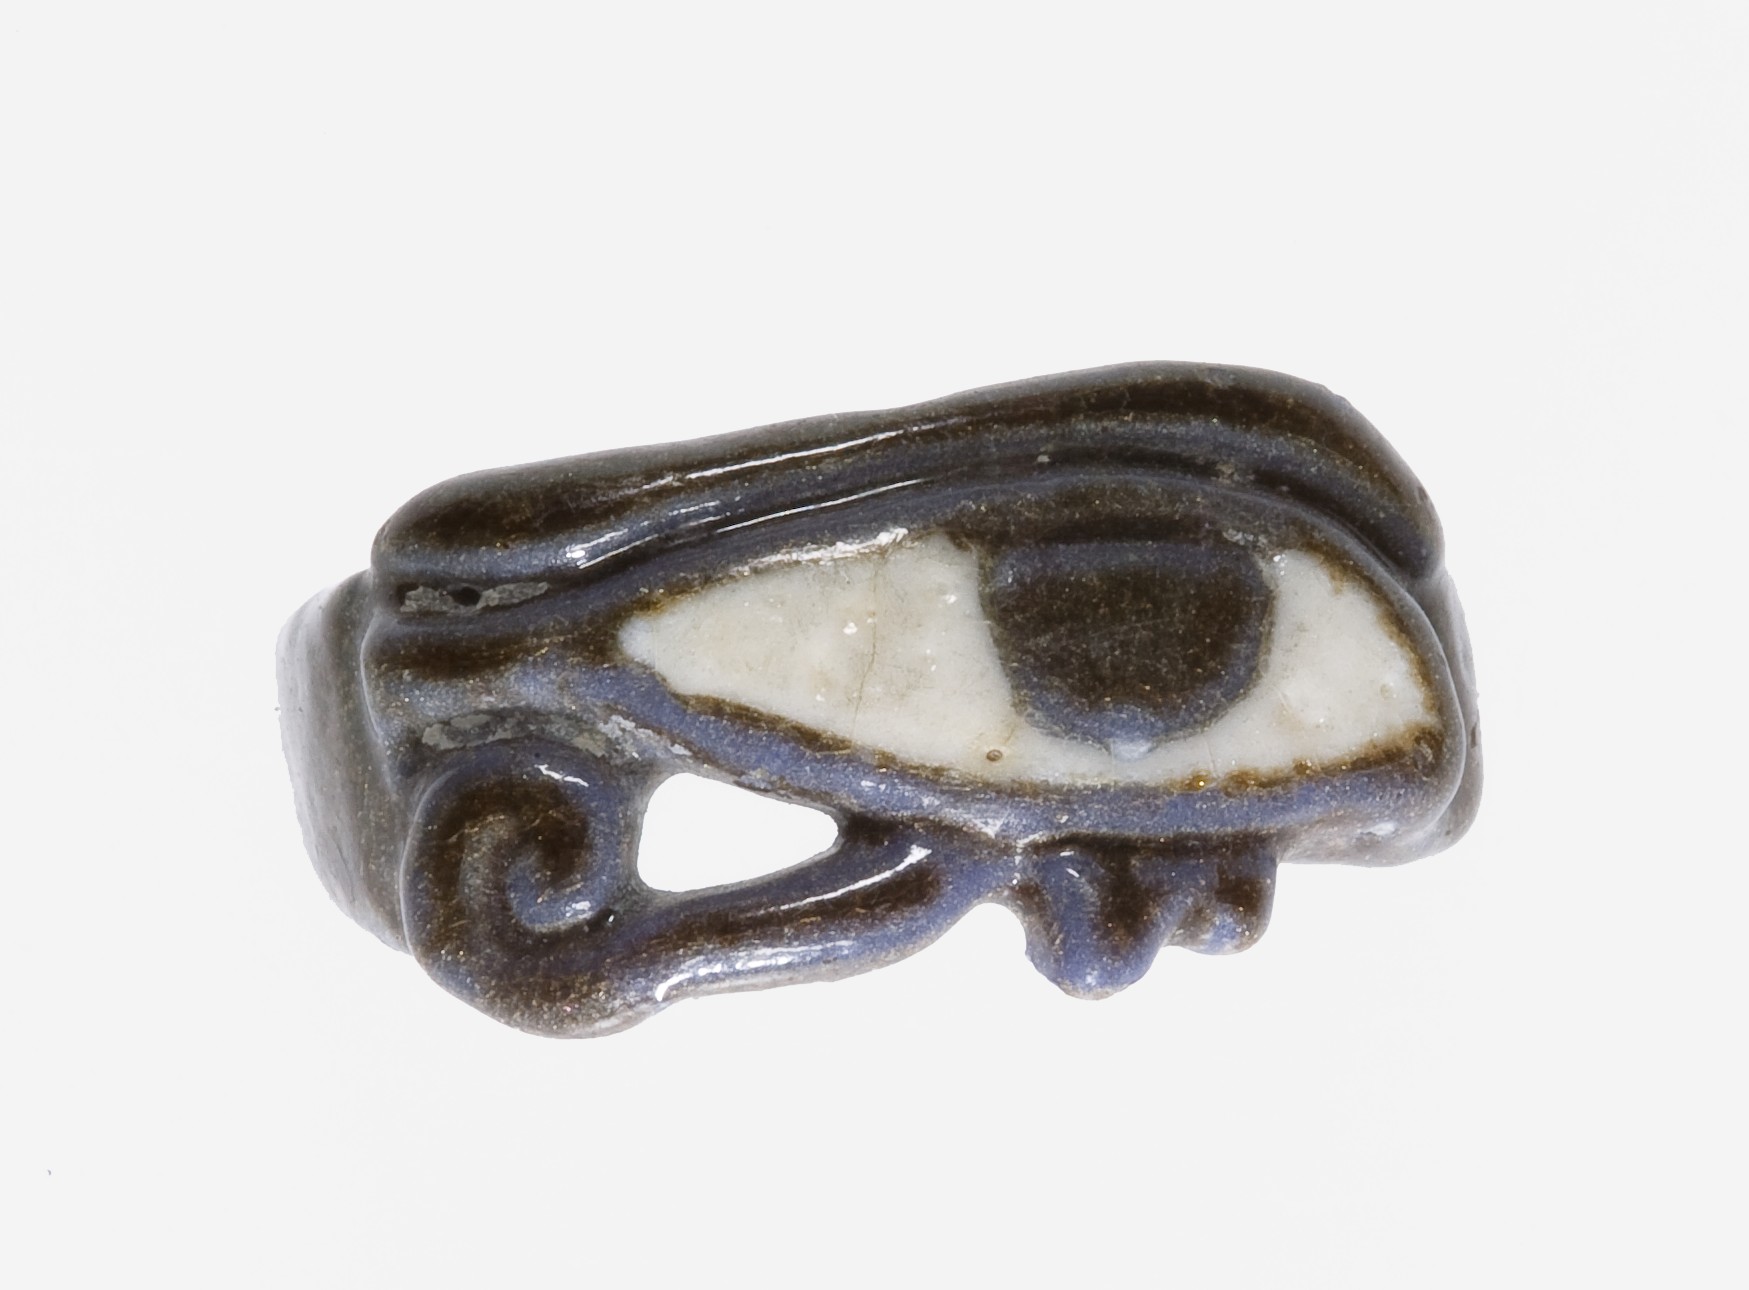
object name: ring, sacred eye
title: Sacred Eye Ring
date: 1390-1352 BCE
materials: faience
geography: egypt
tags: eyes